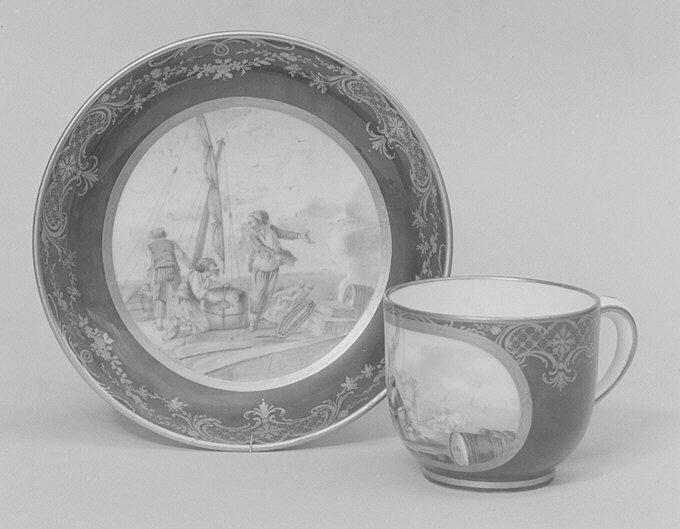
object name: saucer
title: Saucer (part of a service)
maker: sèvres manufactory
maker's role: manufactory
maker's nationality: french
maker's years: 1740-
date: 1775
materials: soft paste porcelain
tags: men,working,ships